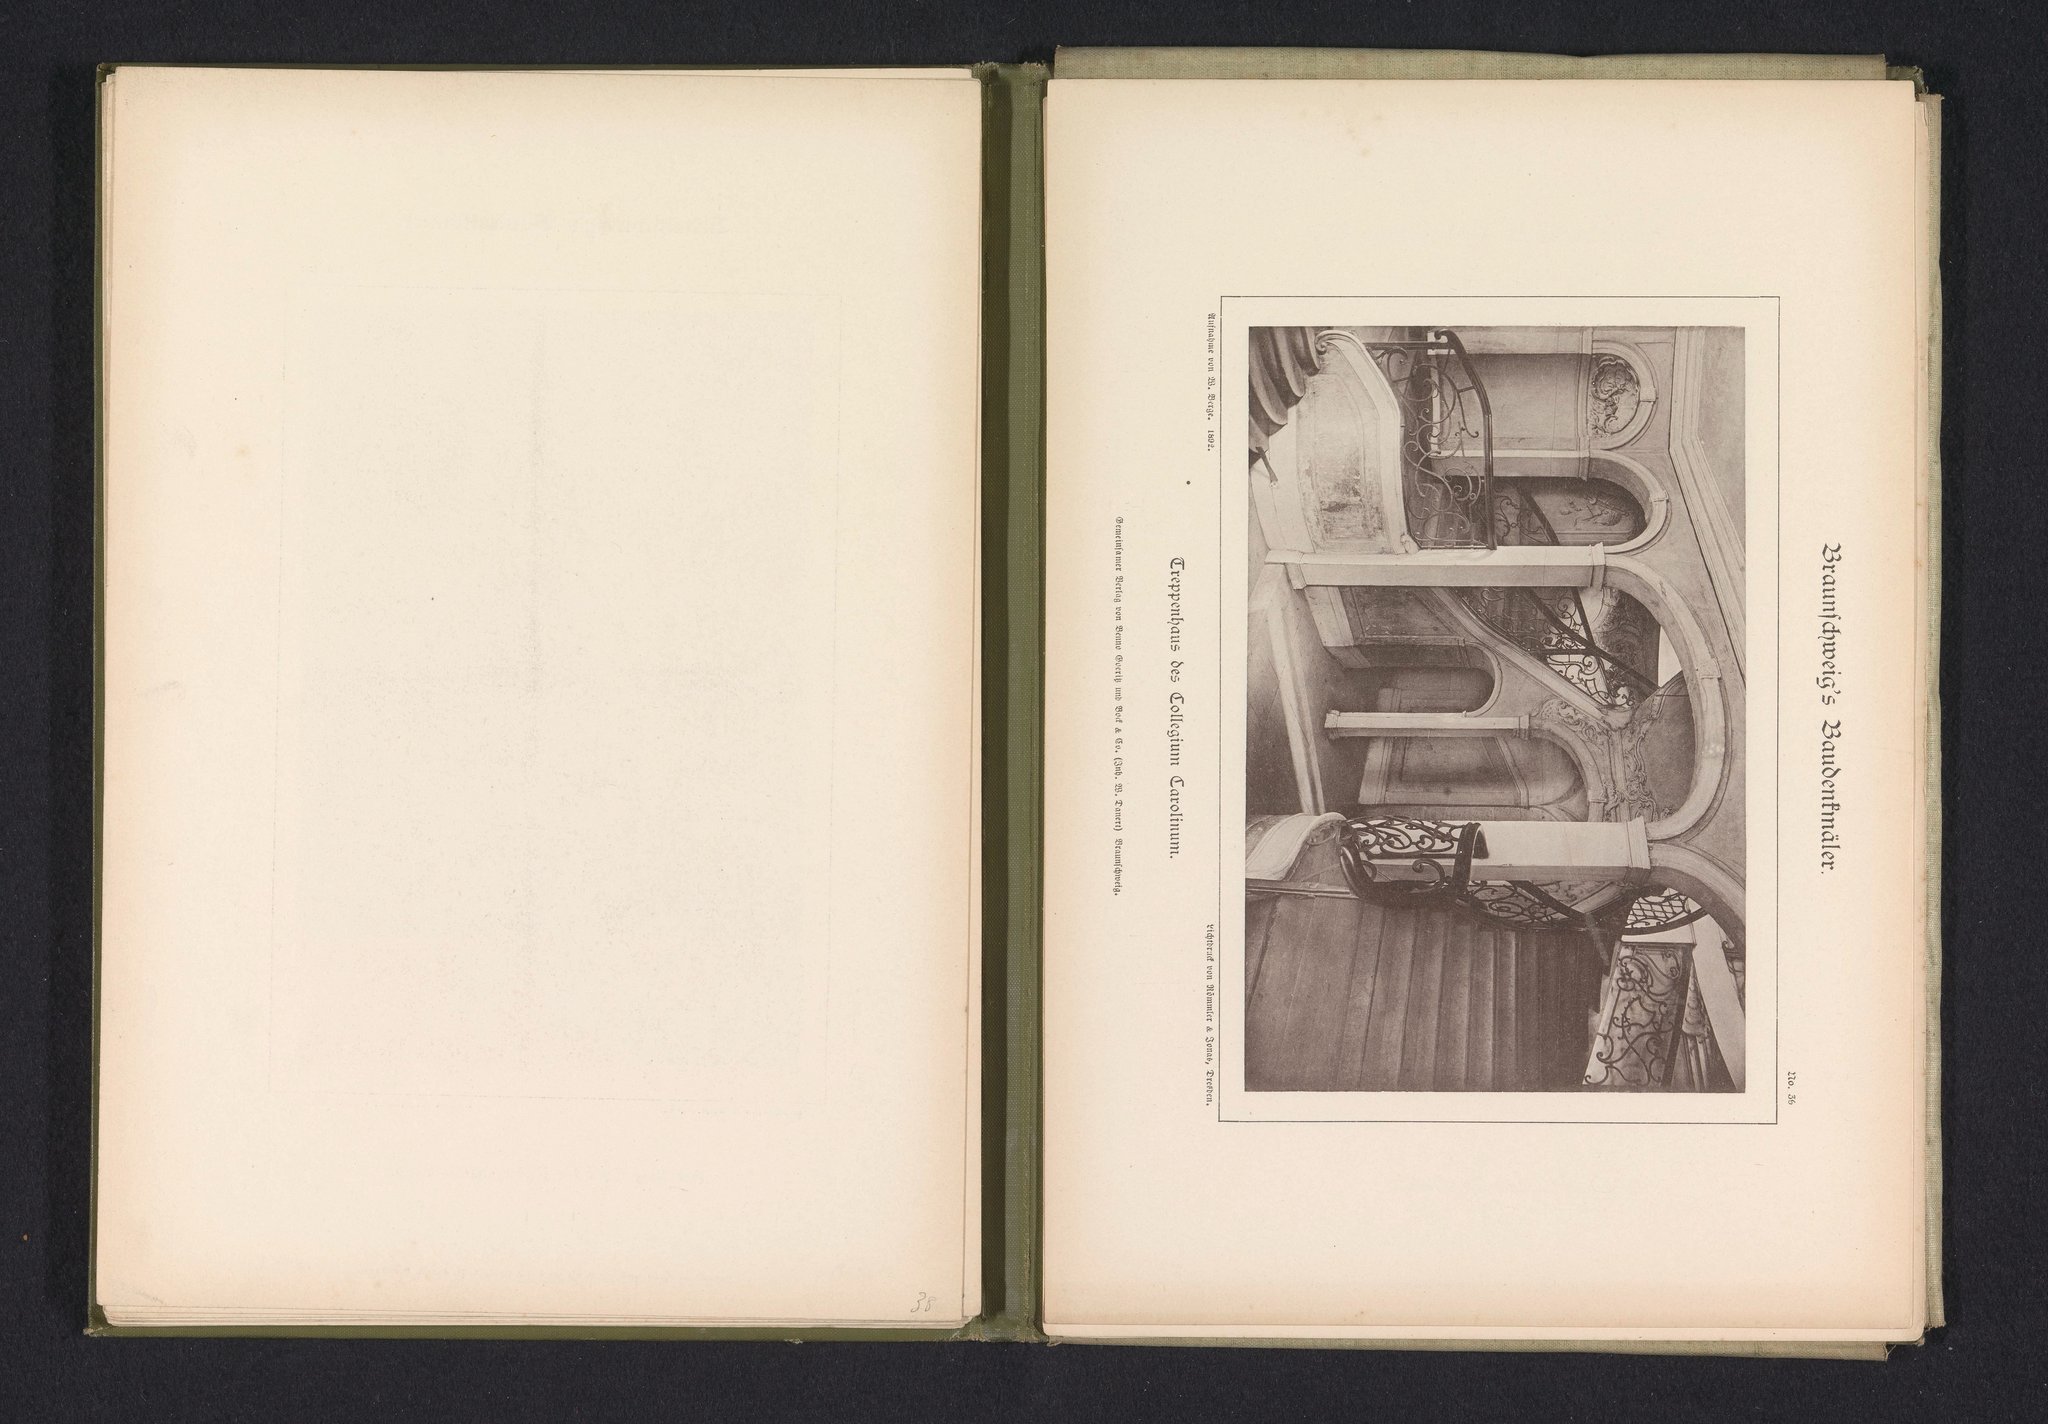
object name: photomechanical print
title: Treppenhaus des Collegium Carolinum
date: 1892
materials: paper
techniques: photograph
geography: collegium carolinum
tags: staircase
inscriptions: number: ‘No. 36.’